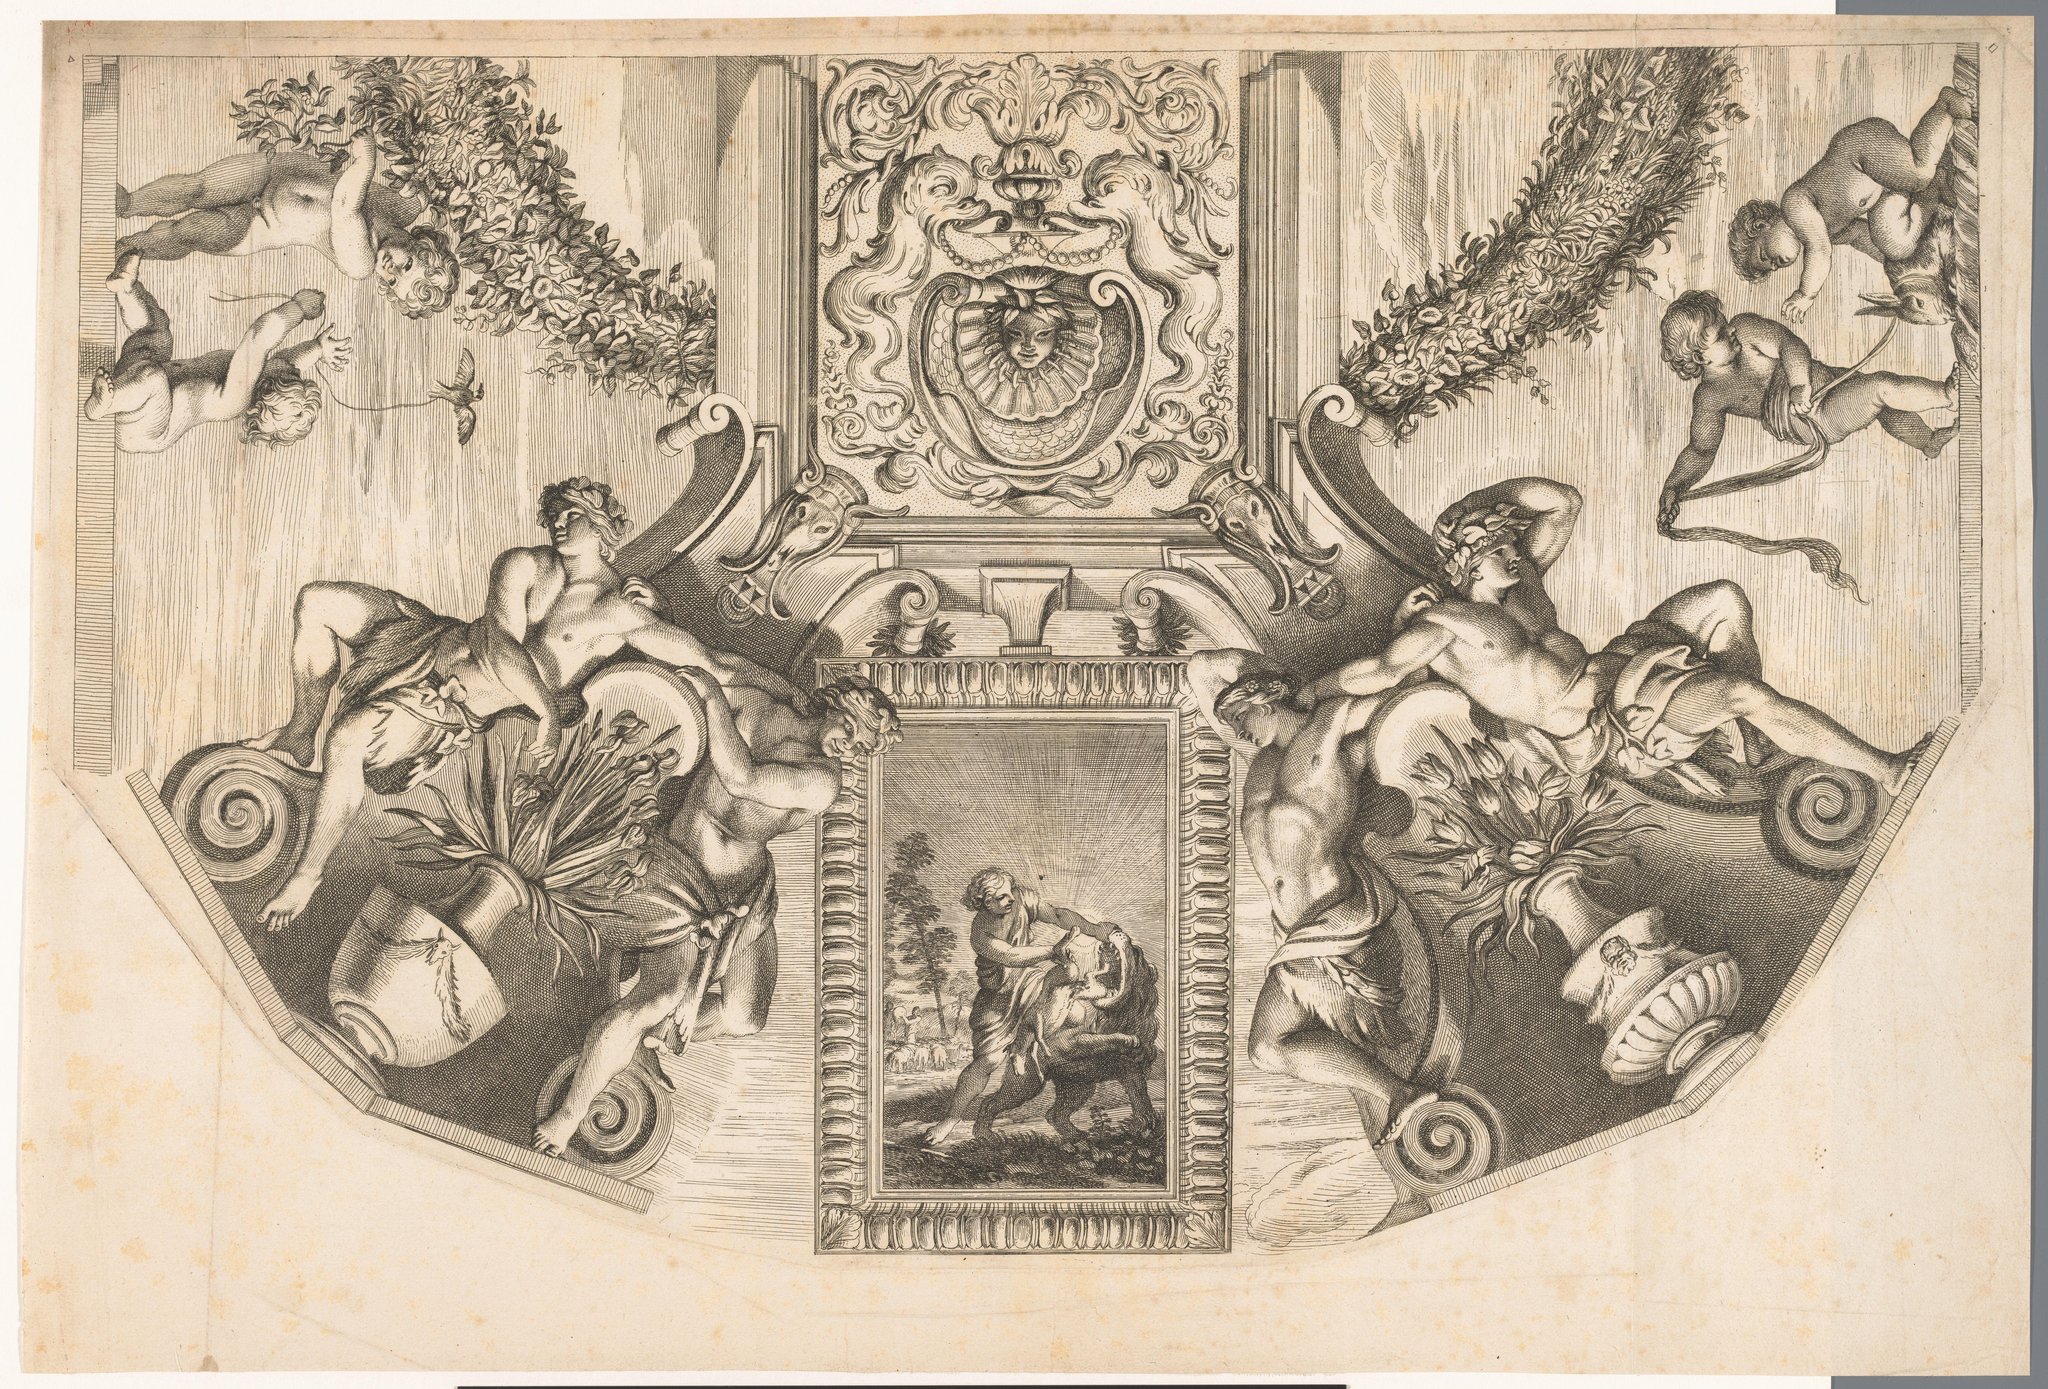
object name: print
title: Detail van verlorengegane plafondschildering in de Villa del Pigneto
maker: gérard audran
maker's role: print maker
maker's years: 1640-1703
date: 1668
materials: paper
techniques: engraving, etching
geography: vatican city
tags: david kills a lion and a bear (or tells saul about it), ornaments ~ art, the (nude) human figure; 'corpo humano' (ripa), cupids: 'amores', 'amoretti', 'putti'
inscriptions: collector's mark: ‘Hinloopen’, collector's mark: Lugt 11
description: Naar een verlorengegane plafondschildering door Pietro da Cortona in Villa del Pigneto te Rome. Deze prent maakte oorspronkelijk deel uit van liber nr. 22 van de Atlas van Rome, uit de collectie Hinloopen. In dit album waren een aantal prentreeksen naar bekende zeventiende eeuwse frescoseries bijeengebonden. In 1709 heeft Schijnvoet op last van de burgemeesters van Amsterdam de collectie herordend. De prenten uit liber 22 kwamen terrecht in Schijnvoet boek nr. 10. De laatst gedateerde reeks in het album is gedateerd 1691. Het album moet dus na deze datum gebonden zijn. De band is in de Rijksakademietijd uit elkaar gehaald. De marges van de prenten zijn bij het opbergen in het Rijksprentenkabinet vaak drastisch afgesneden. Van een aantal series waren de prenten teruggeslagen om in het album te passen. (Zie: Waals, Jan van der. De prentschat van Michiel Hinloopen. 's-Gravenhage: SDU uitgeverij, 1988, pp. 173-174.)